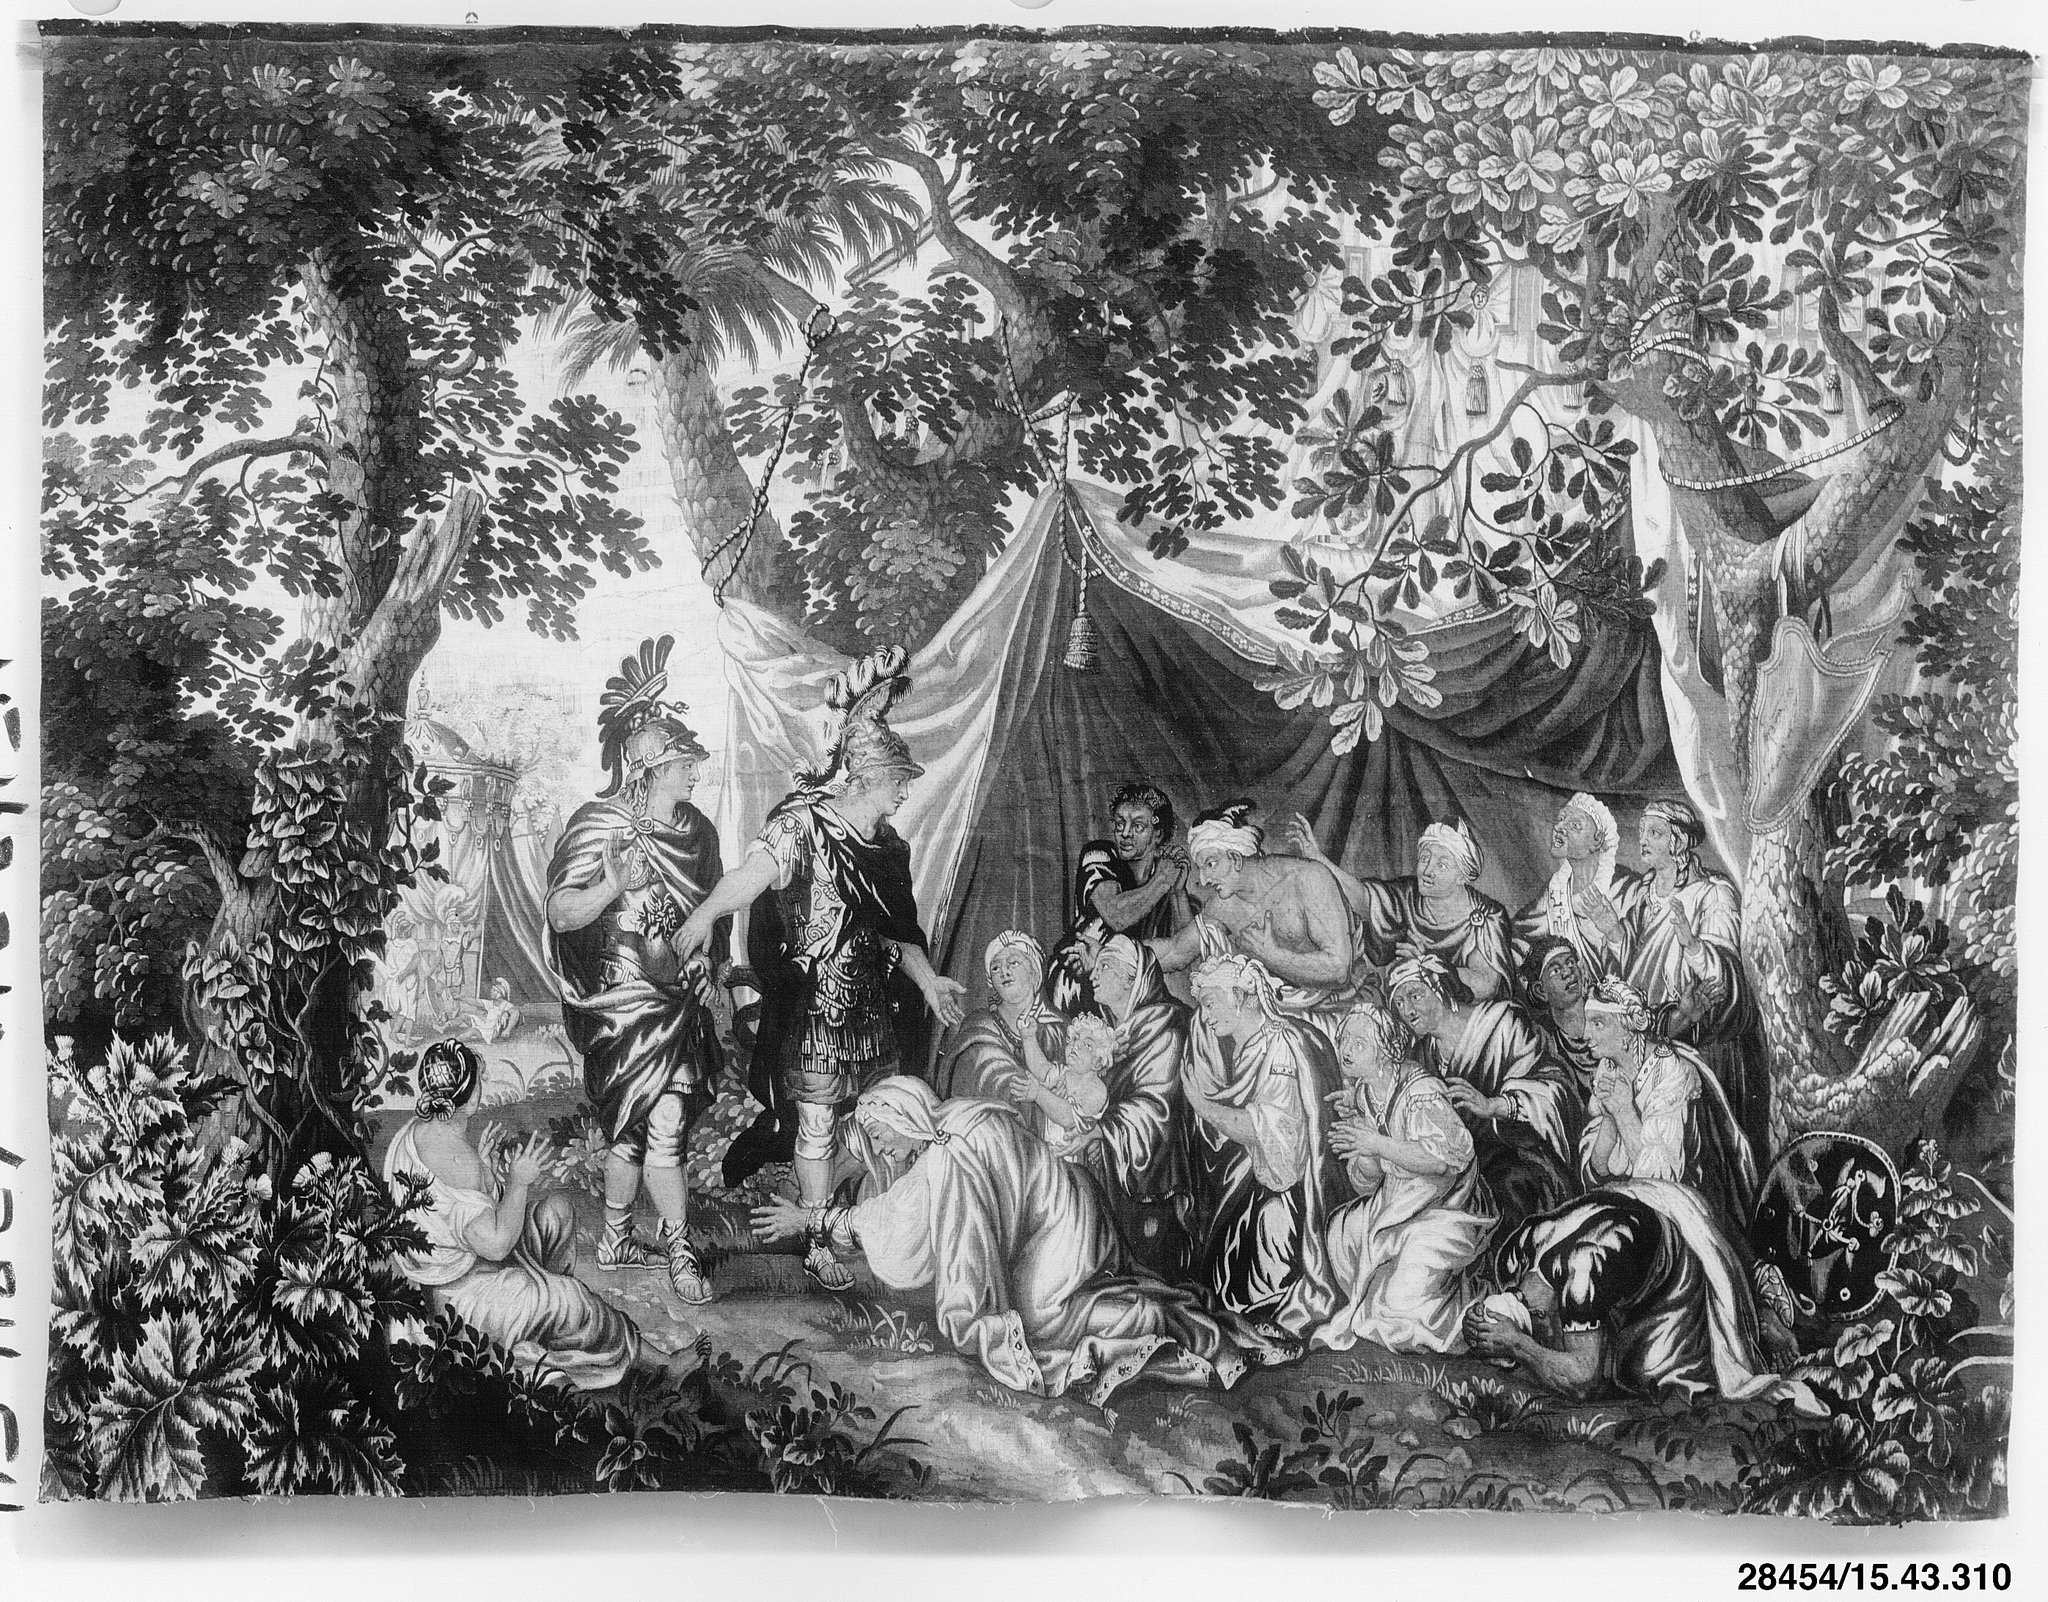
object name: tapestry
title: Alexander and the Family of Darius from a set of The Story of Alexander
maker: charles le brun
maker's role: artist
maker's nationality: french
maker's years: 1619-1690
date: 1700-1735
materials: silk, wool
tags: tents,alexander the great,men,women,forests